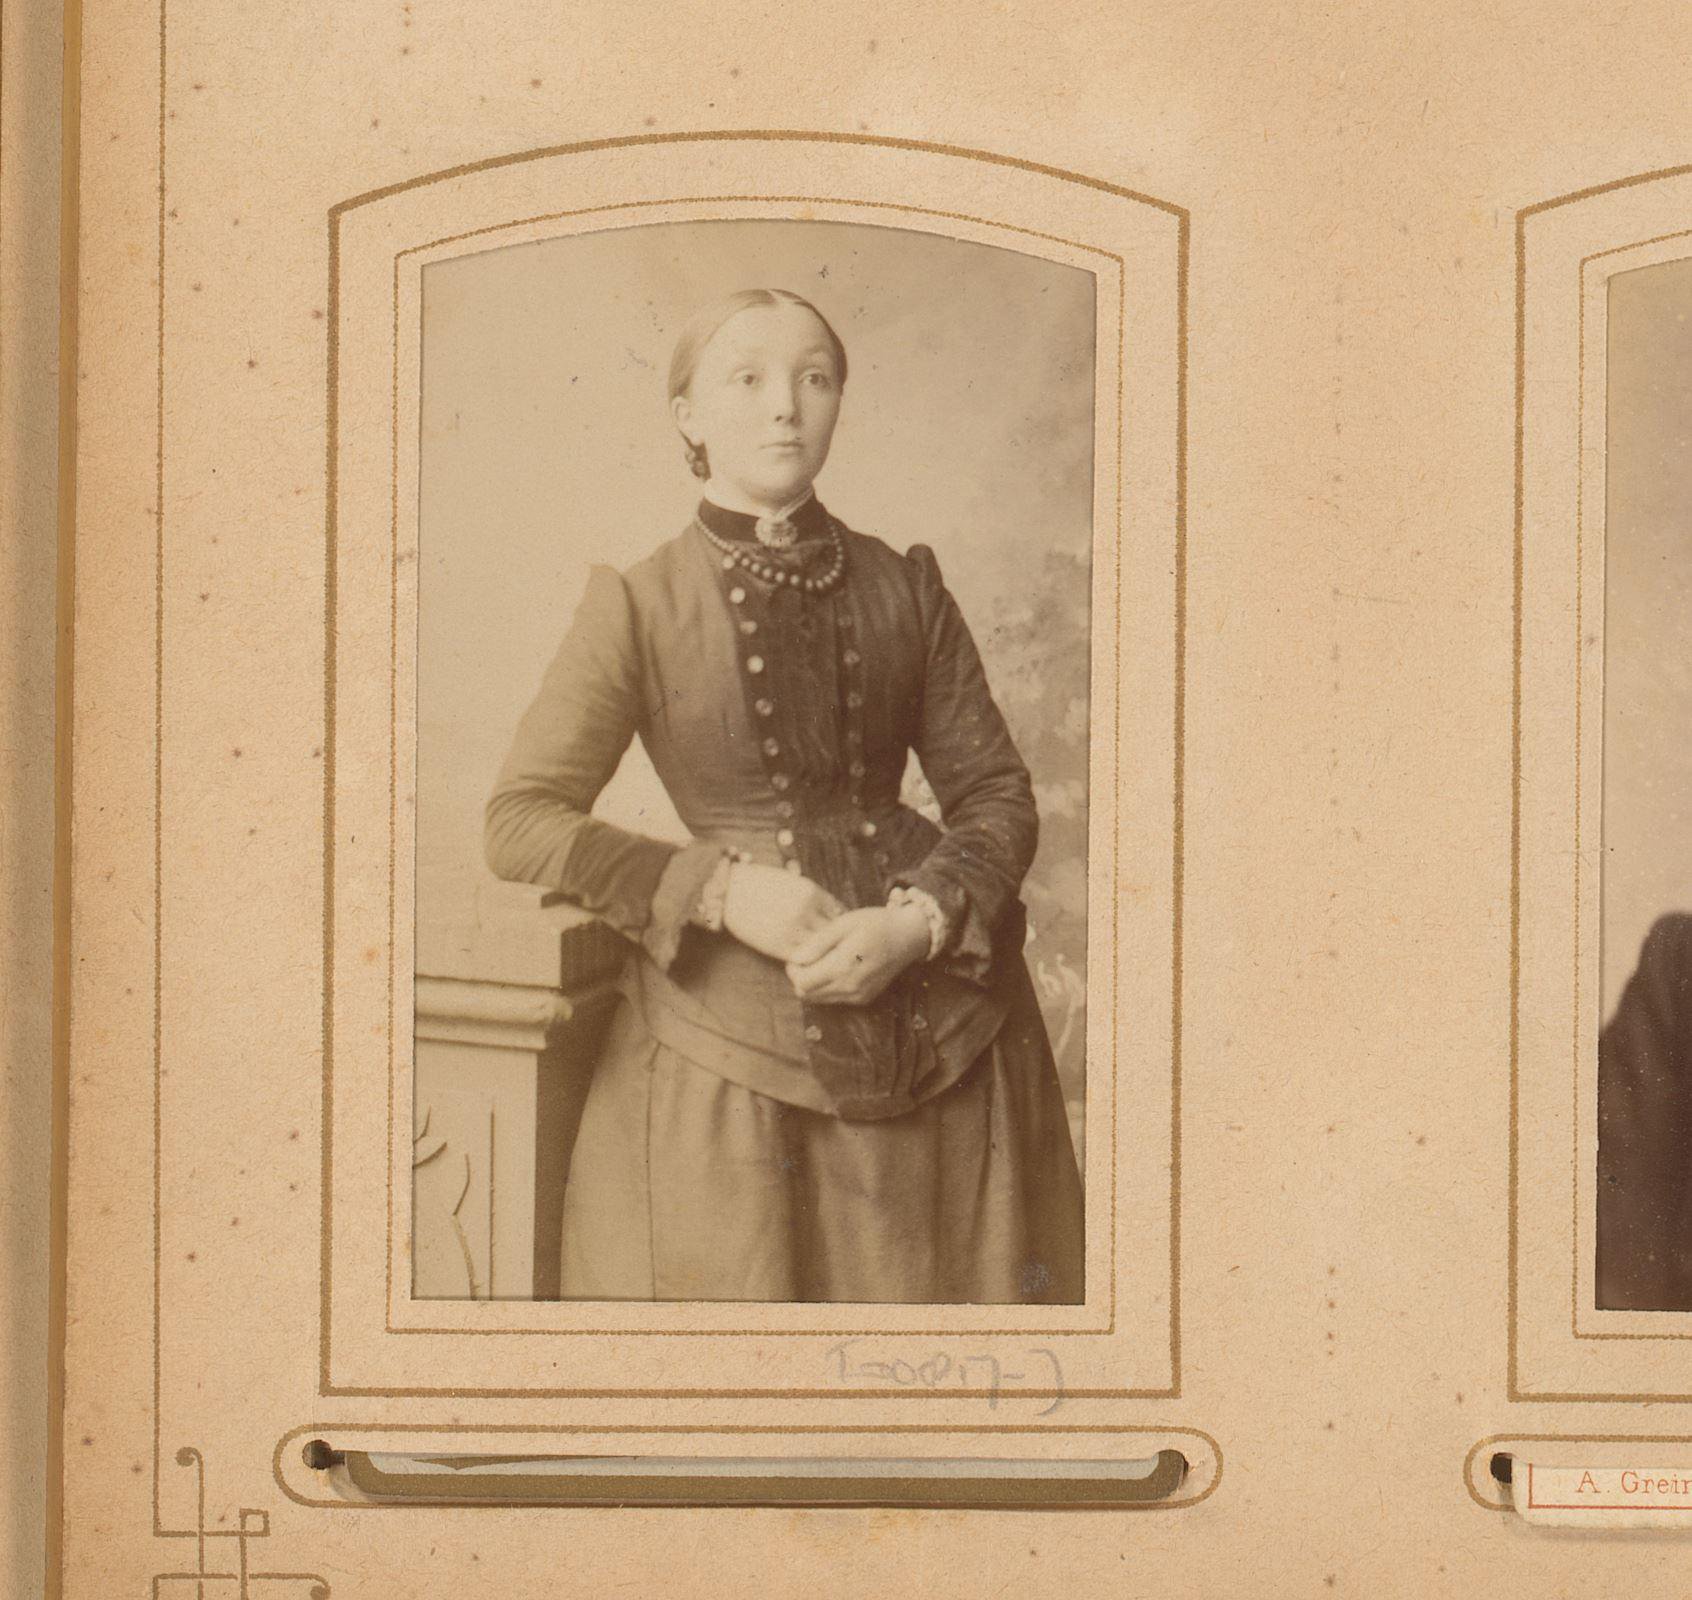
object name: album leaf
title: Portret van een staande vrouw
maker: willem oldenkamp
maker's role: fotograaf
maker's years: 1864-1921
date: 1885-1915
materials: cardboard, photographic support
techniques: albumen print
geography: netherlands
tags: historical persons - bb - woman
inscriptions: inscription: ‘Photografische inrichtingen van/ W. Oldenkamp/ Arnhem/ Ridderstraat 22/ Wageningen/ naast het station’